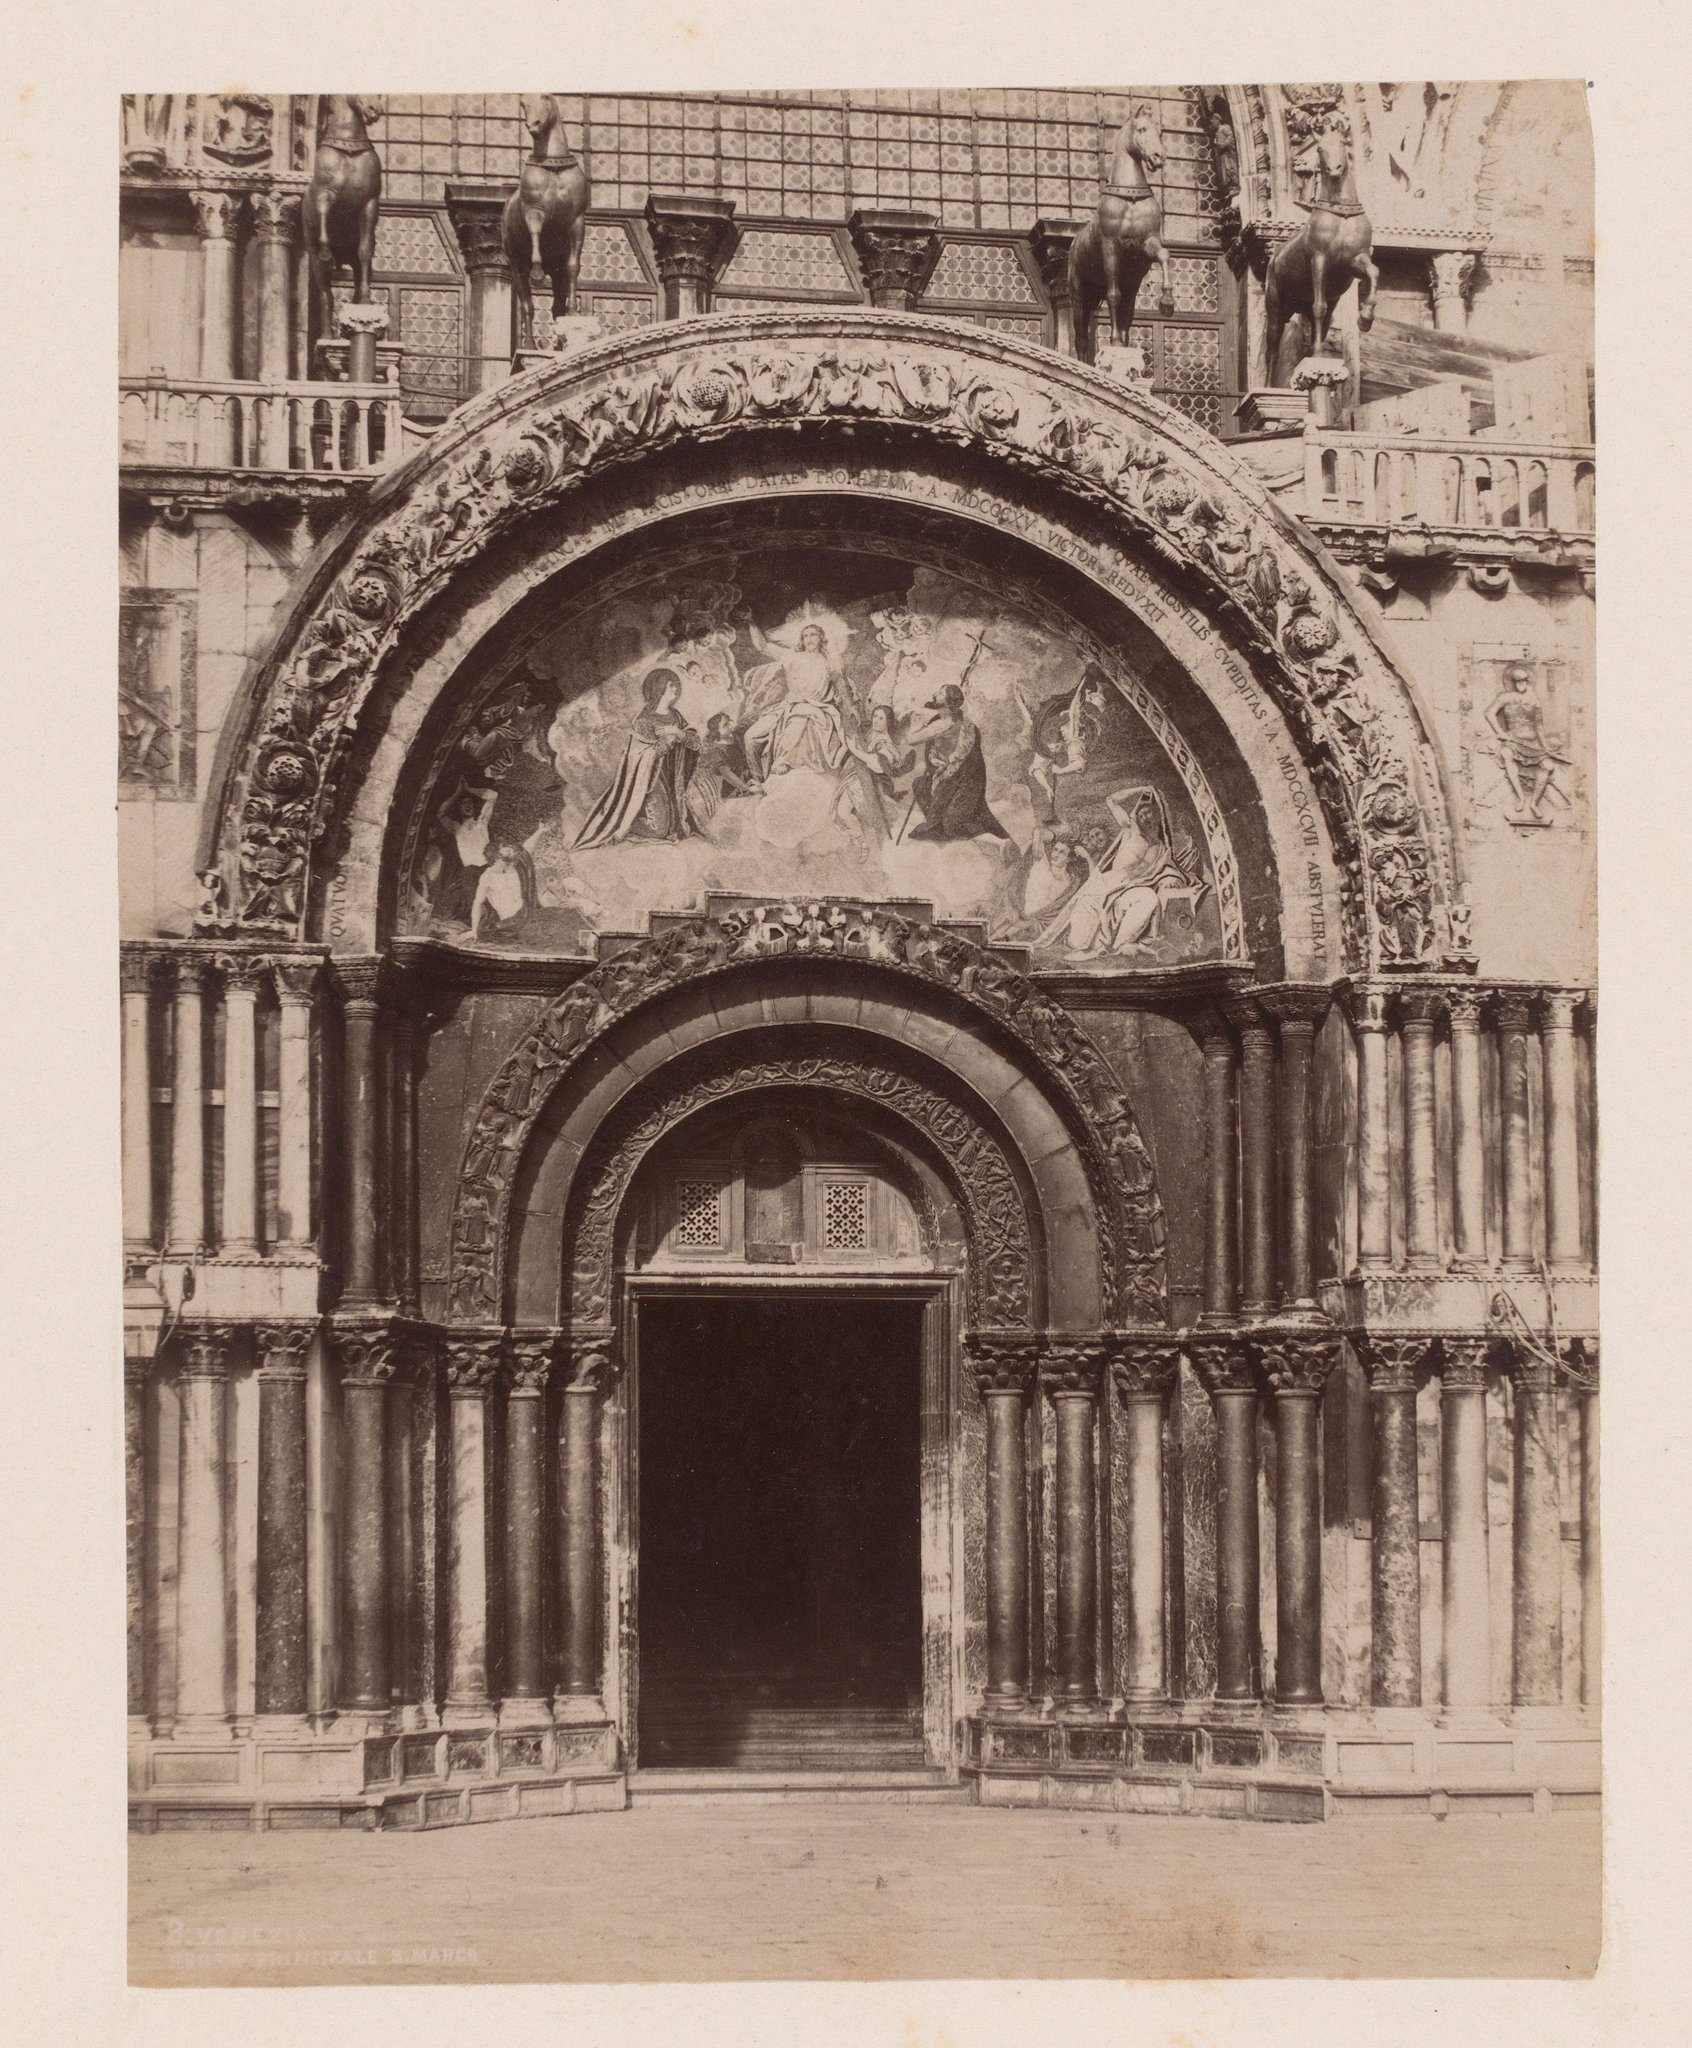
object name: photograph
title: Porta principale S. Marco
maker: Anonymous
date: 1851-1900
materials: cardboard, paper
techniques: albumen print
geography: venice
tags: parts of church exterior and annexes: portal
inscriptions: number: ‘8.’